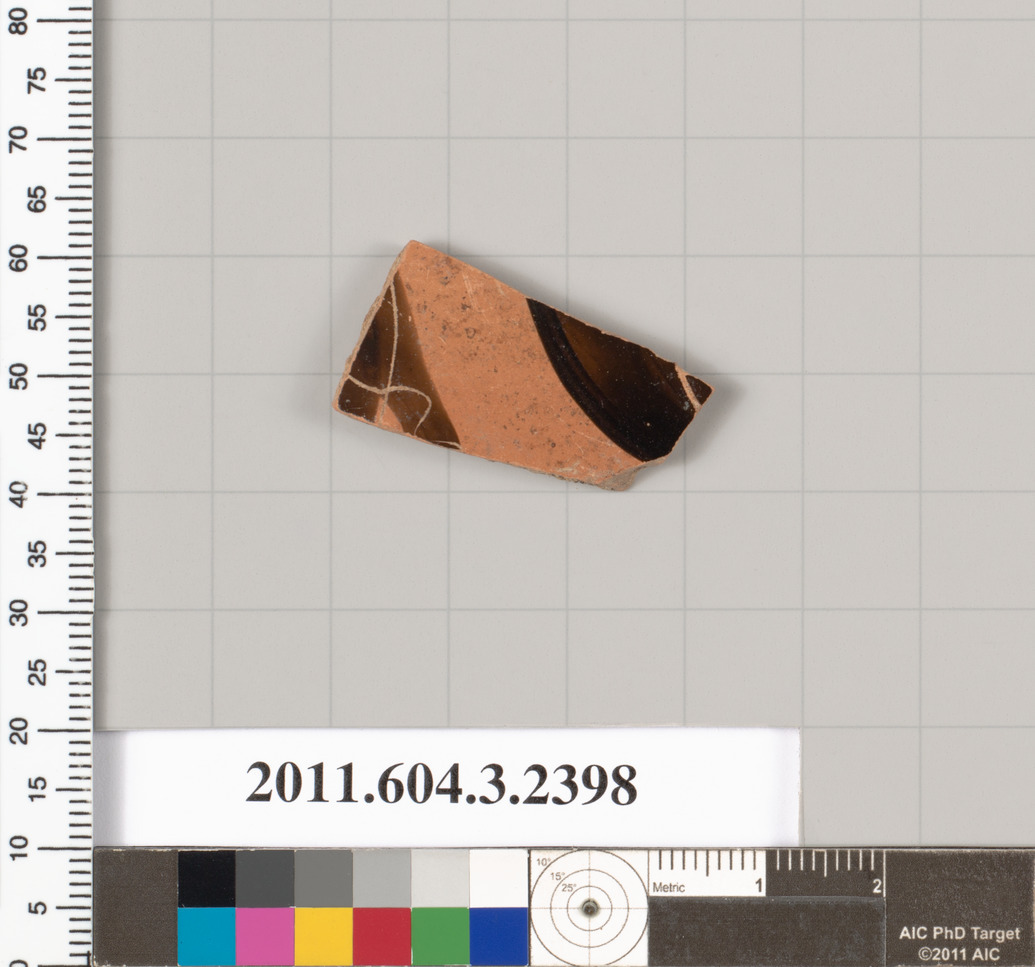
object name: kylix fragment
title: Terracotta fragment of a kylix: eye-cup (drinking cup)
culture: greek, attic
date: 525-501 BCE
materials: terracotta